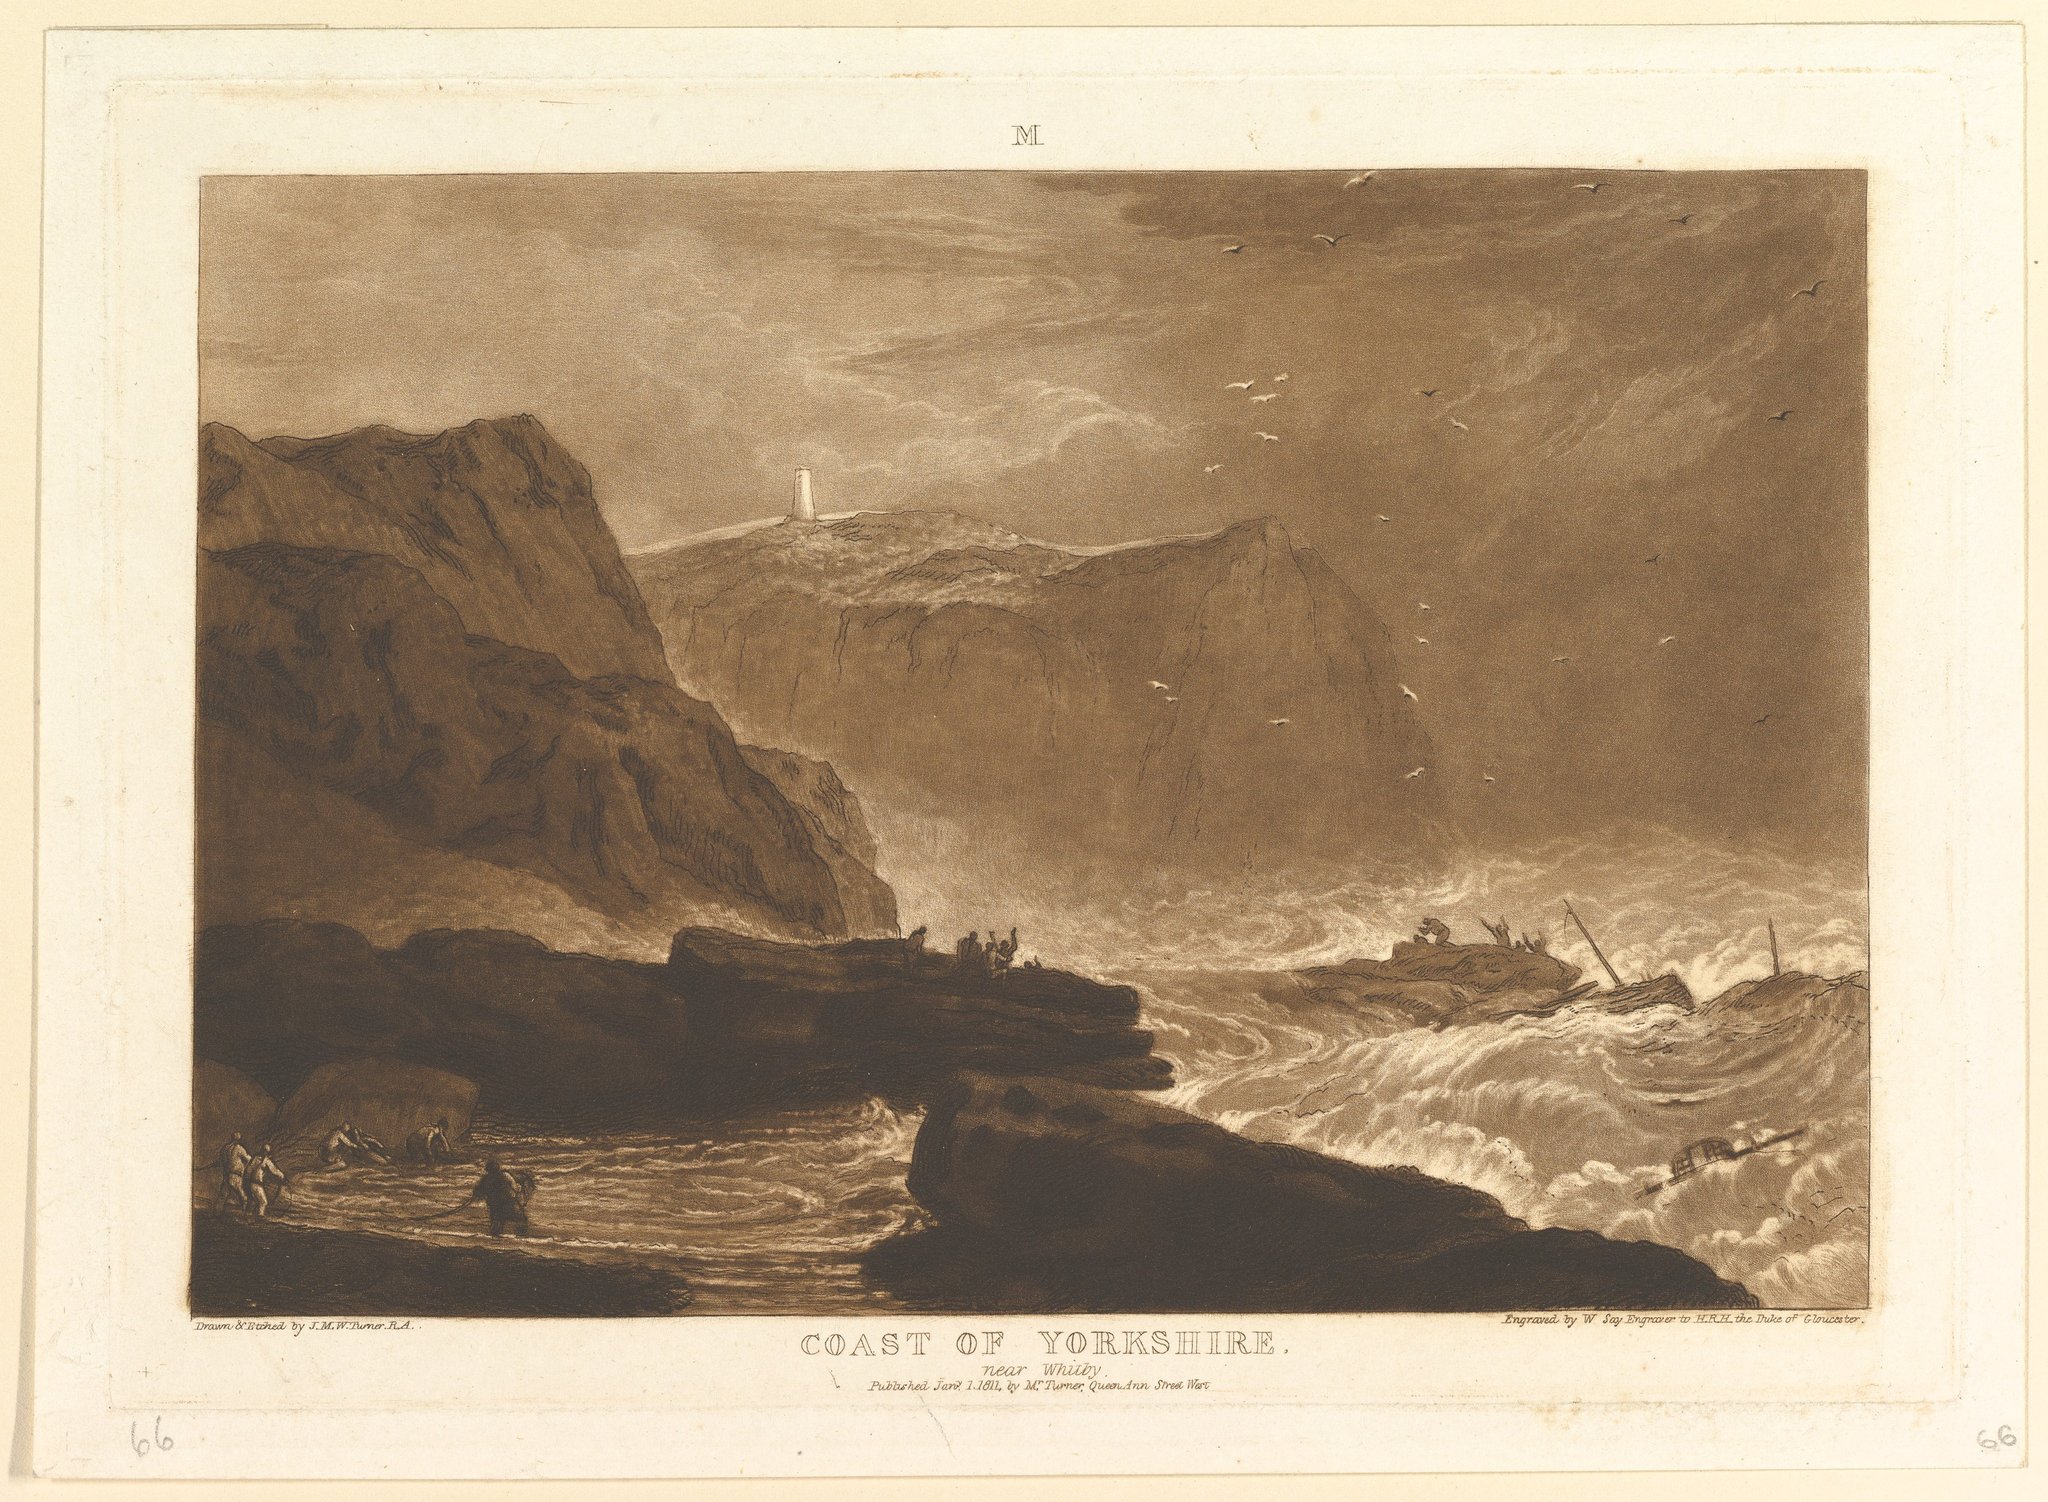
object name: print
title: Coast of Yorkshire, Near Whitby (Liber Studiorum, part V, plate 24)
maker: joseph mallord william turner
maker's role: artist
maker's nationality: british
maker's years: 1775-1851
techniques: etching, mezzotint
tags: landscapes,boats